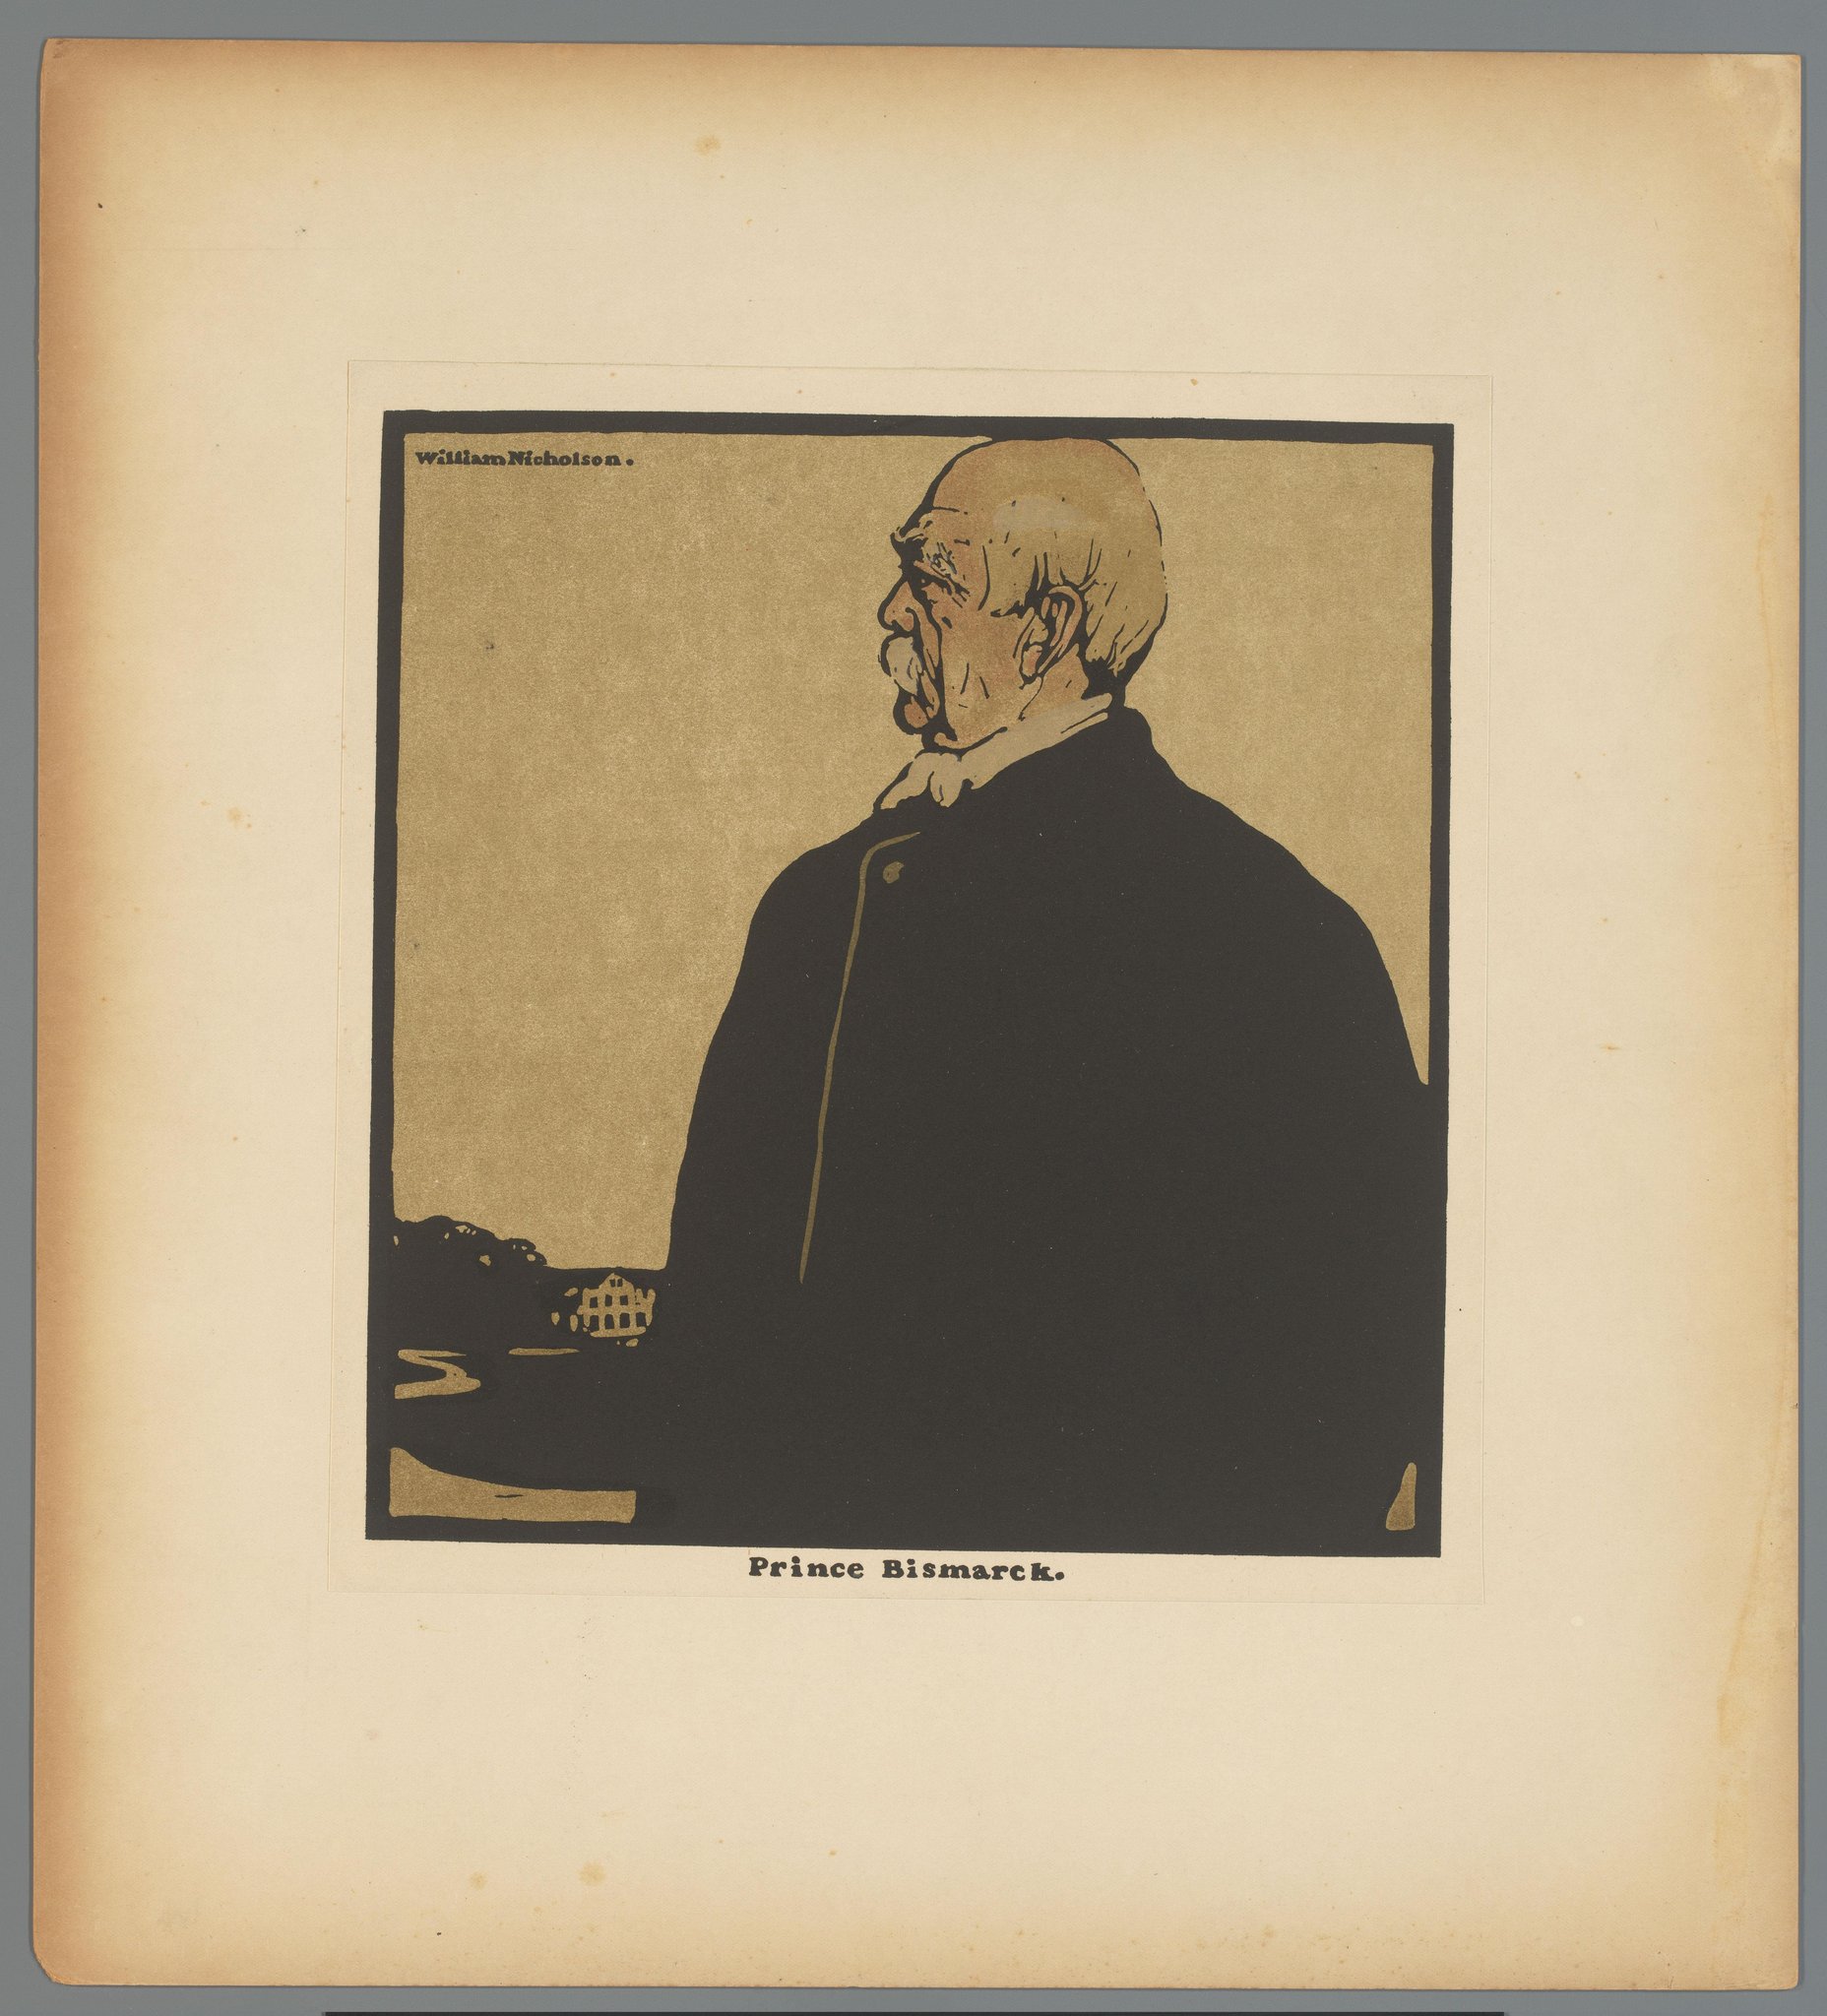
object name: print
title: Douze Portraits par William Nicholson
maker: henri floury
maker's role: publisher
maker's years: 1862-1961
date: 1900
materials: paper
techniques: lithograph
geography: paris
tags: historical persons, politician, e.g. party leader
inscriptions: collector's mark: Lugt 2760, collector's mark: Lugt 2228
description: De serie met lithografieën is gemaakt naar ontwerpen van houtsneden door William Nicholson.